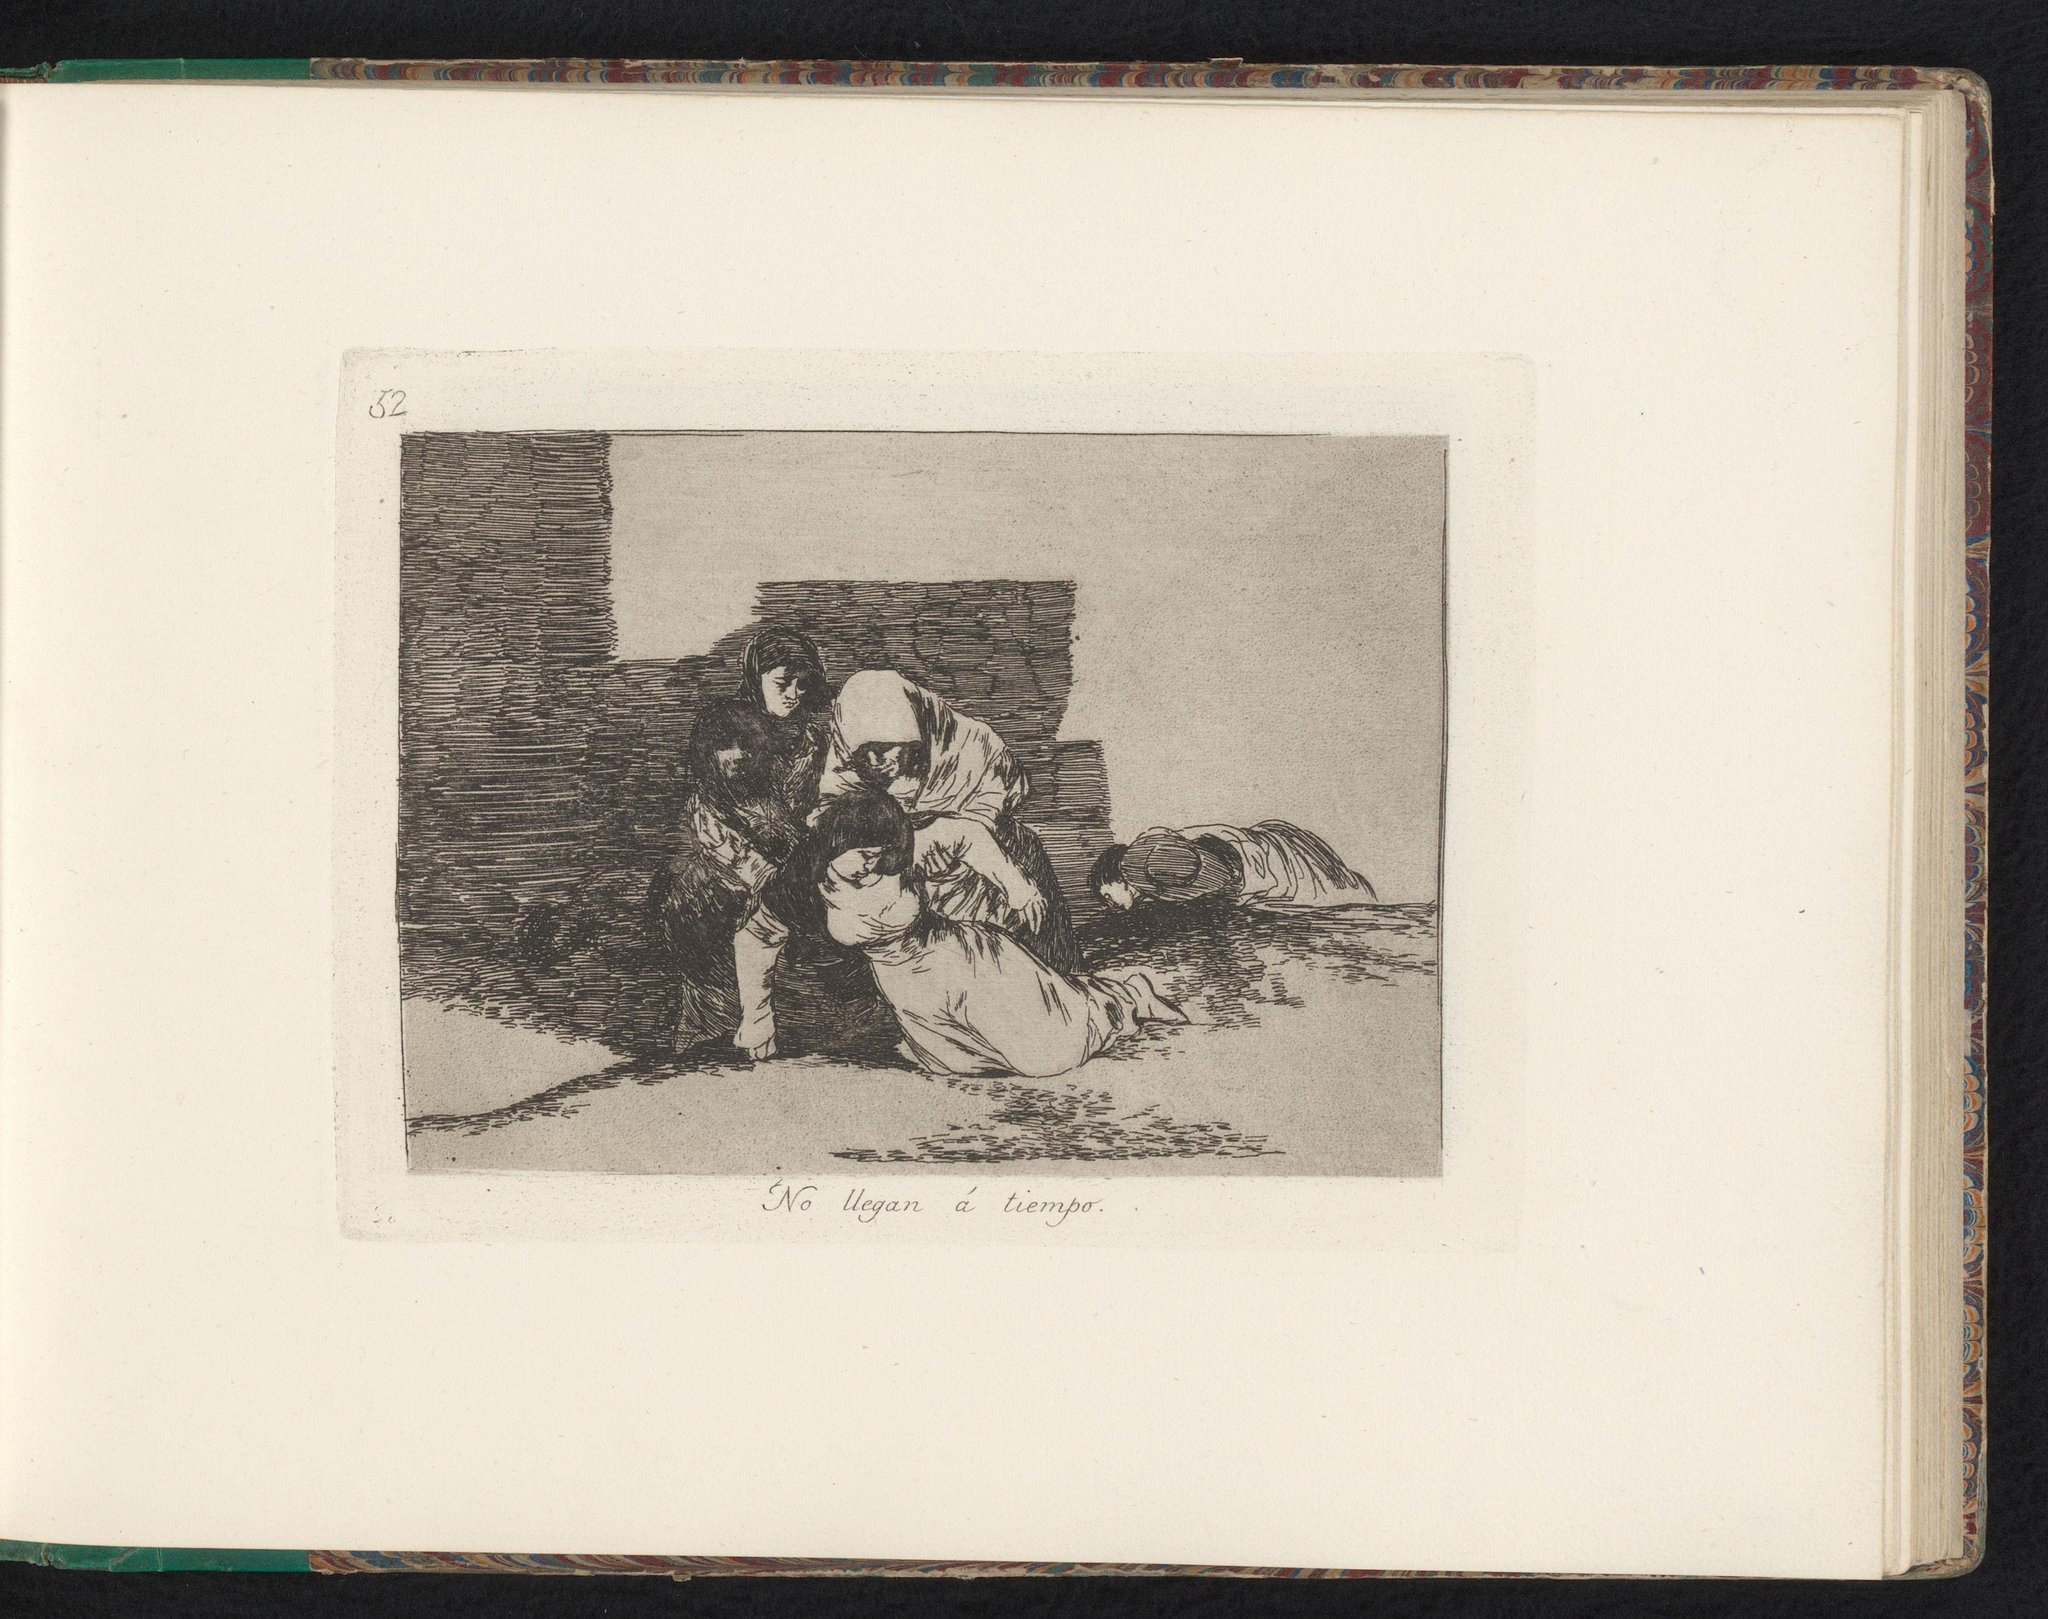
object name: print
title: Los desastres de la guerra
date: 1810-1820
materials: paper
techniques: aquatint, drypoint, engraving, etching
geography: madrid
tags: finding a dead person, horrors of war, mourning the dead, spain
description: Deze prent maakt deel uit van een album.